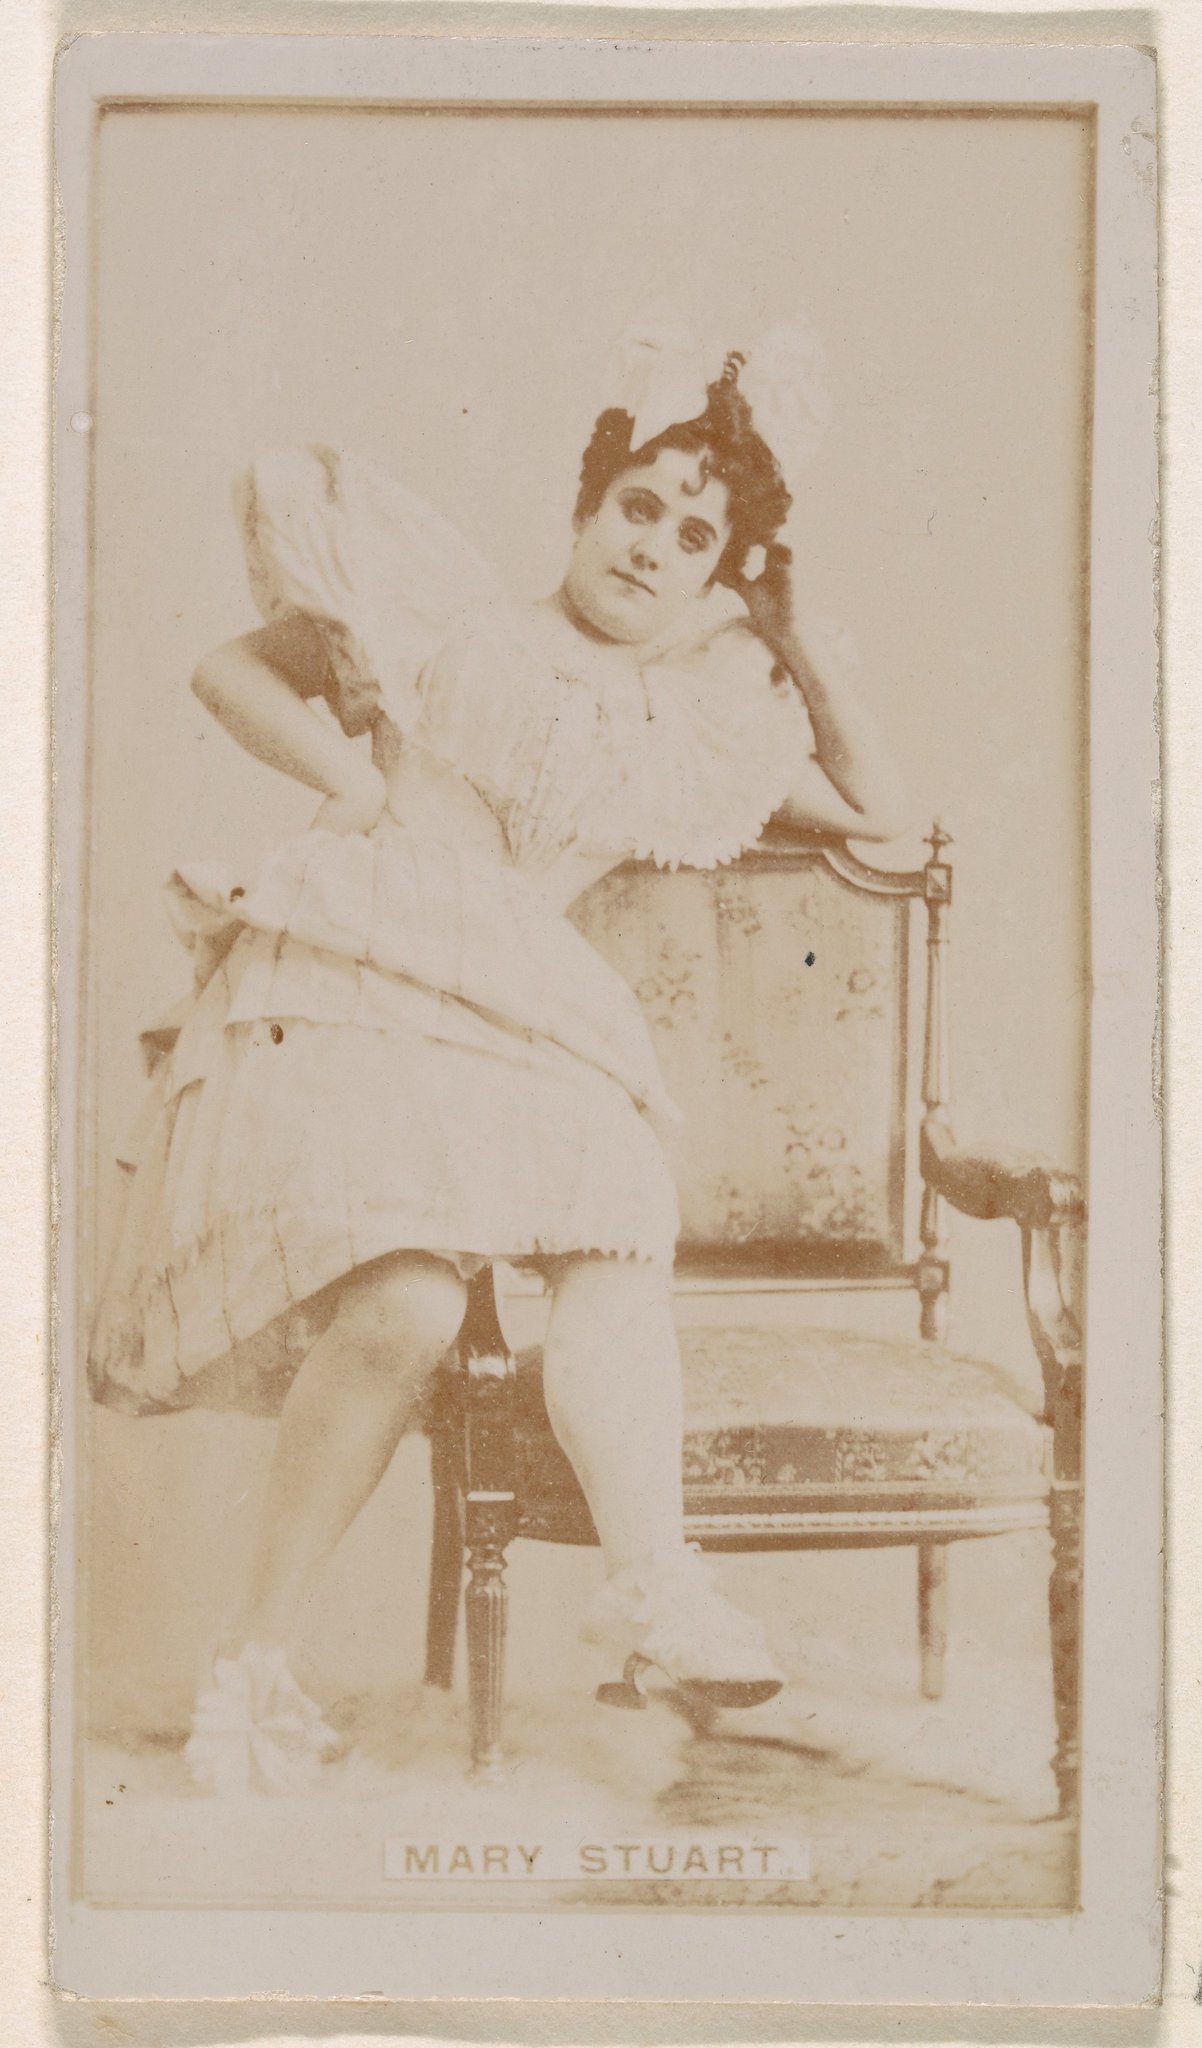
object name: photograph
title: Mary Stuart, from the Actresses series (N245) issued by Kinney Brothers to promote Sweet Caporal Cigarettes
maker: kinney brothers tobacco company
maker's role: publisher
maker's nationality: american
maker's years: 1869-2011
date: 1890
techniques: albumen silver print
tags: portraits,women,actresses